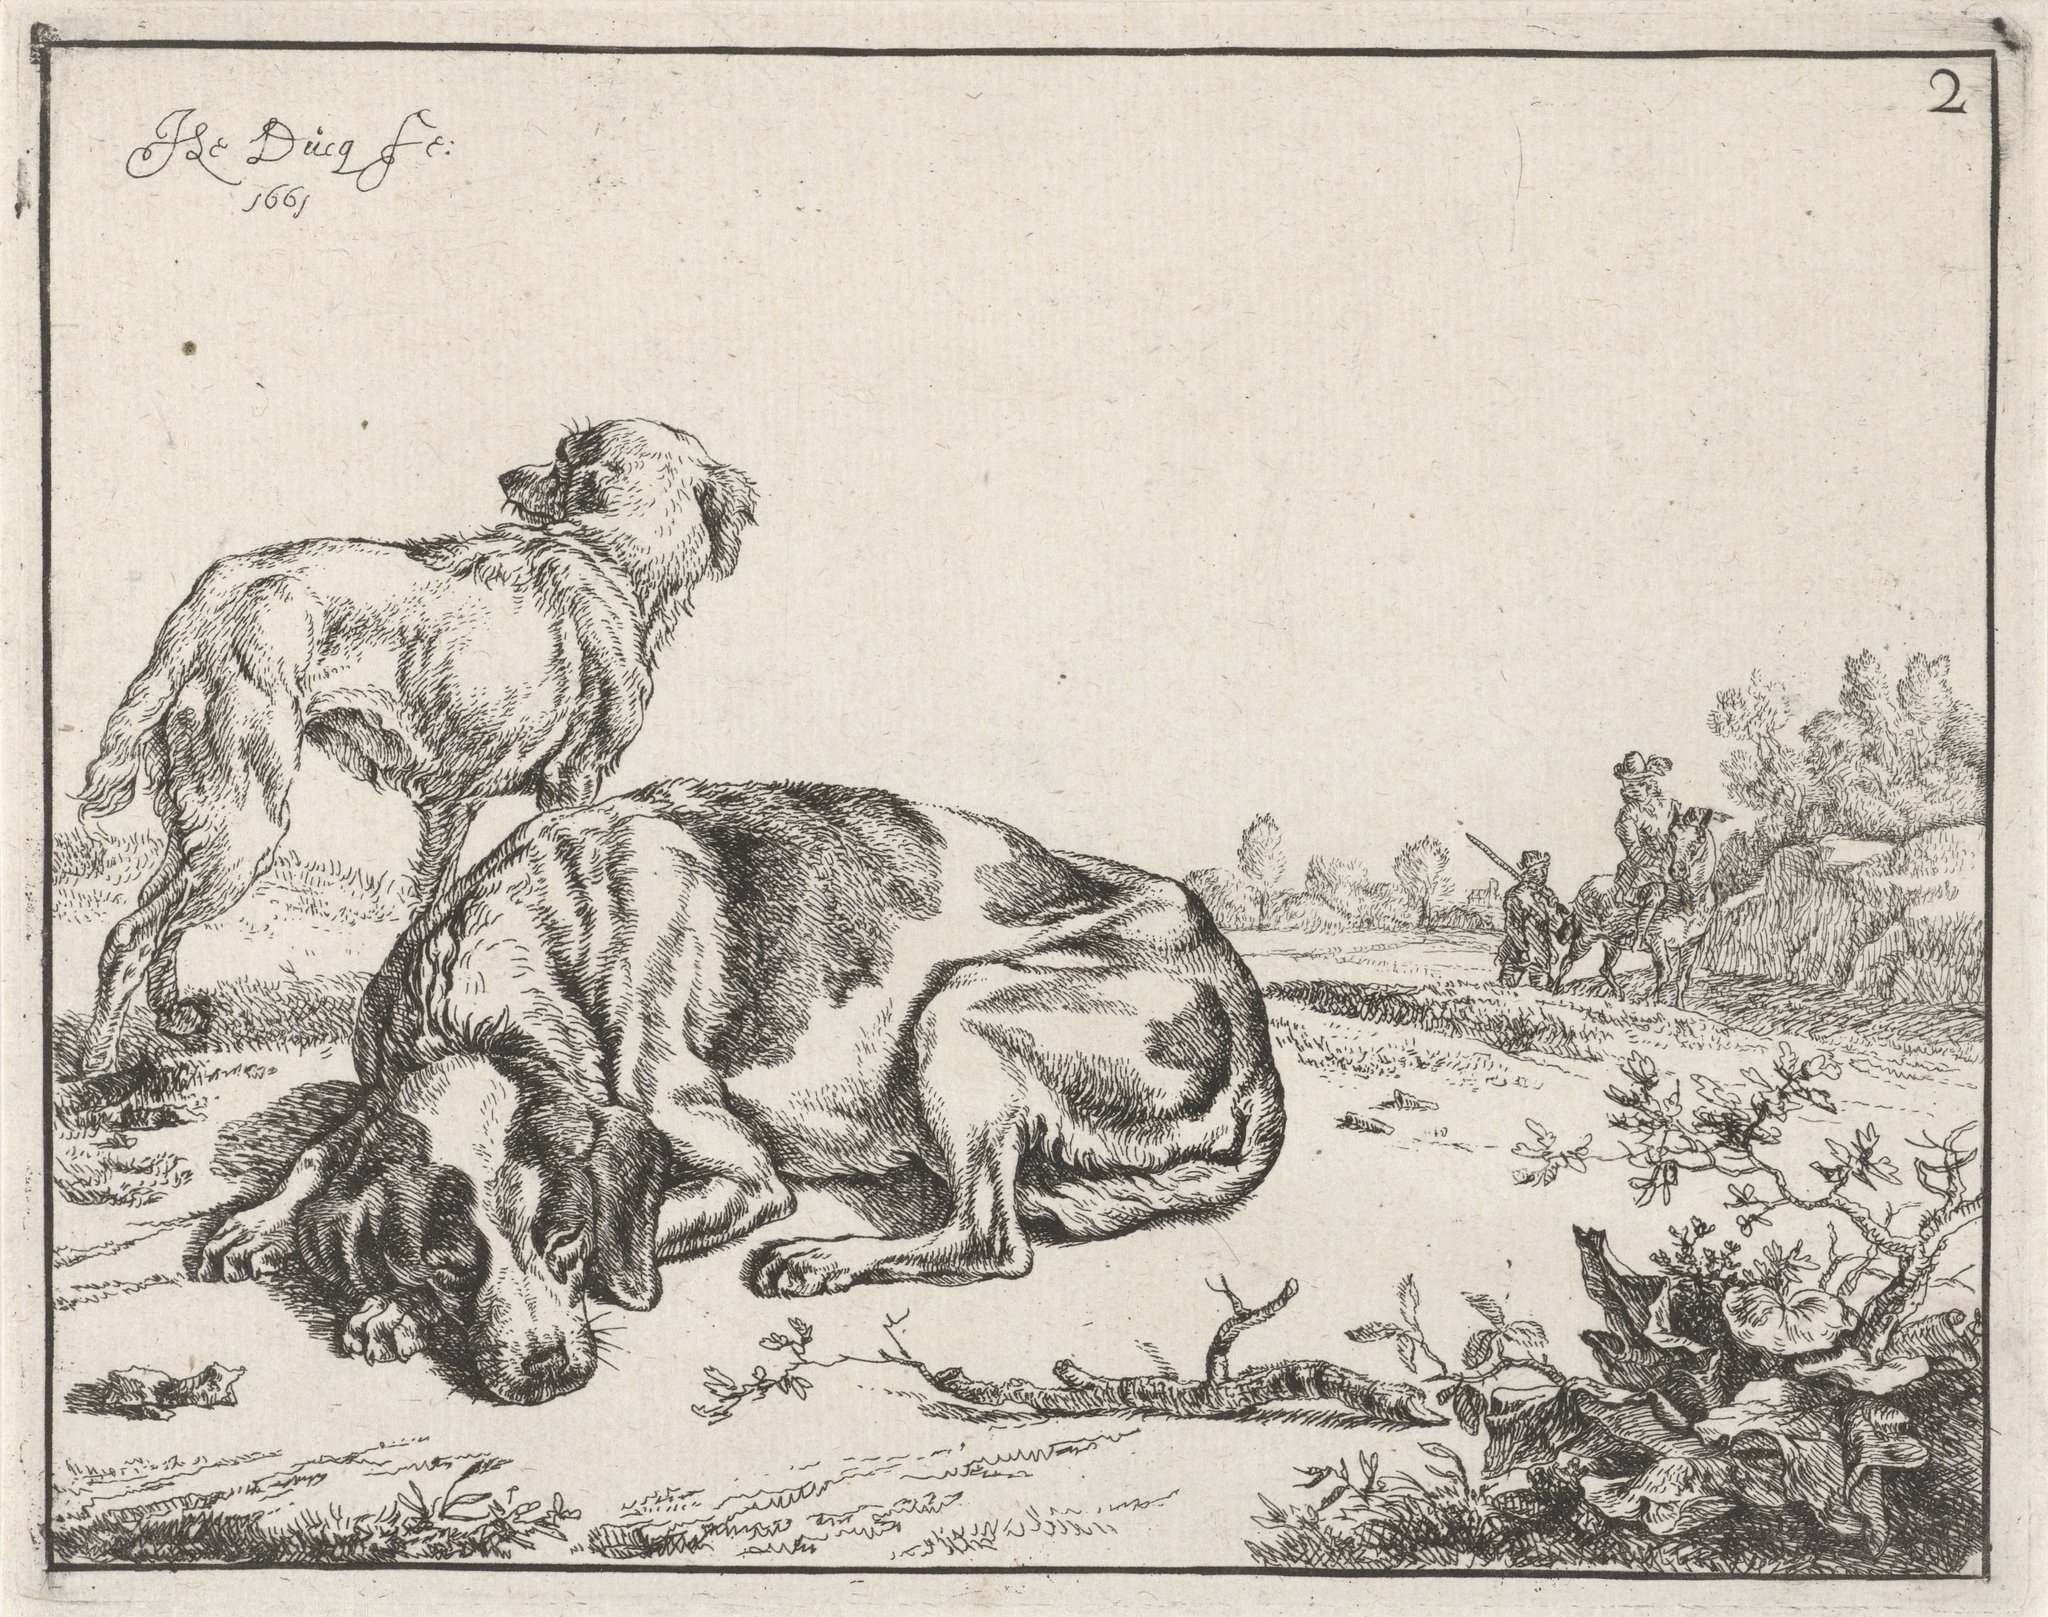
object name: print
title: Honden in een landschap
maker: johan le ducq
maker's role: draughtsman, print maker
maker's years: 1629-1677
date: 1661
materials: paper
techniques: etching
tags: riding a horse, ass, or mule; rider, horseman, landscapes (+ landscape with figures, staffage), dog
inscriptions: collector's mark: Lugt 240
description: Een liggende en staande hond in een landschap, in de verte een figuur te voet en een te paard. De prent maakt deel uit van een achtdelige serie prenten met voorstellingen van honden in een landschap.